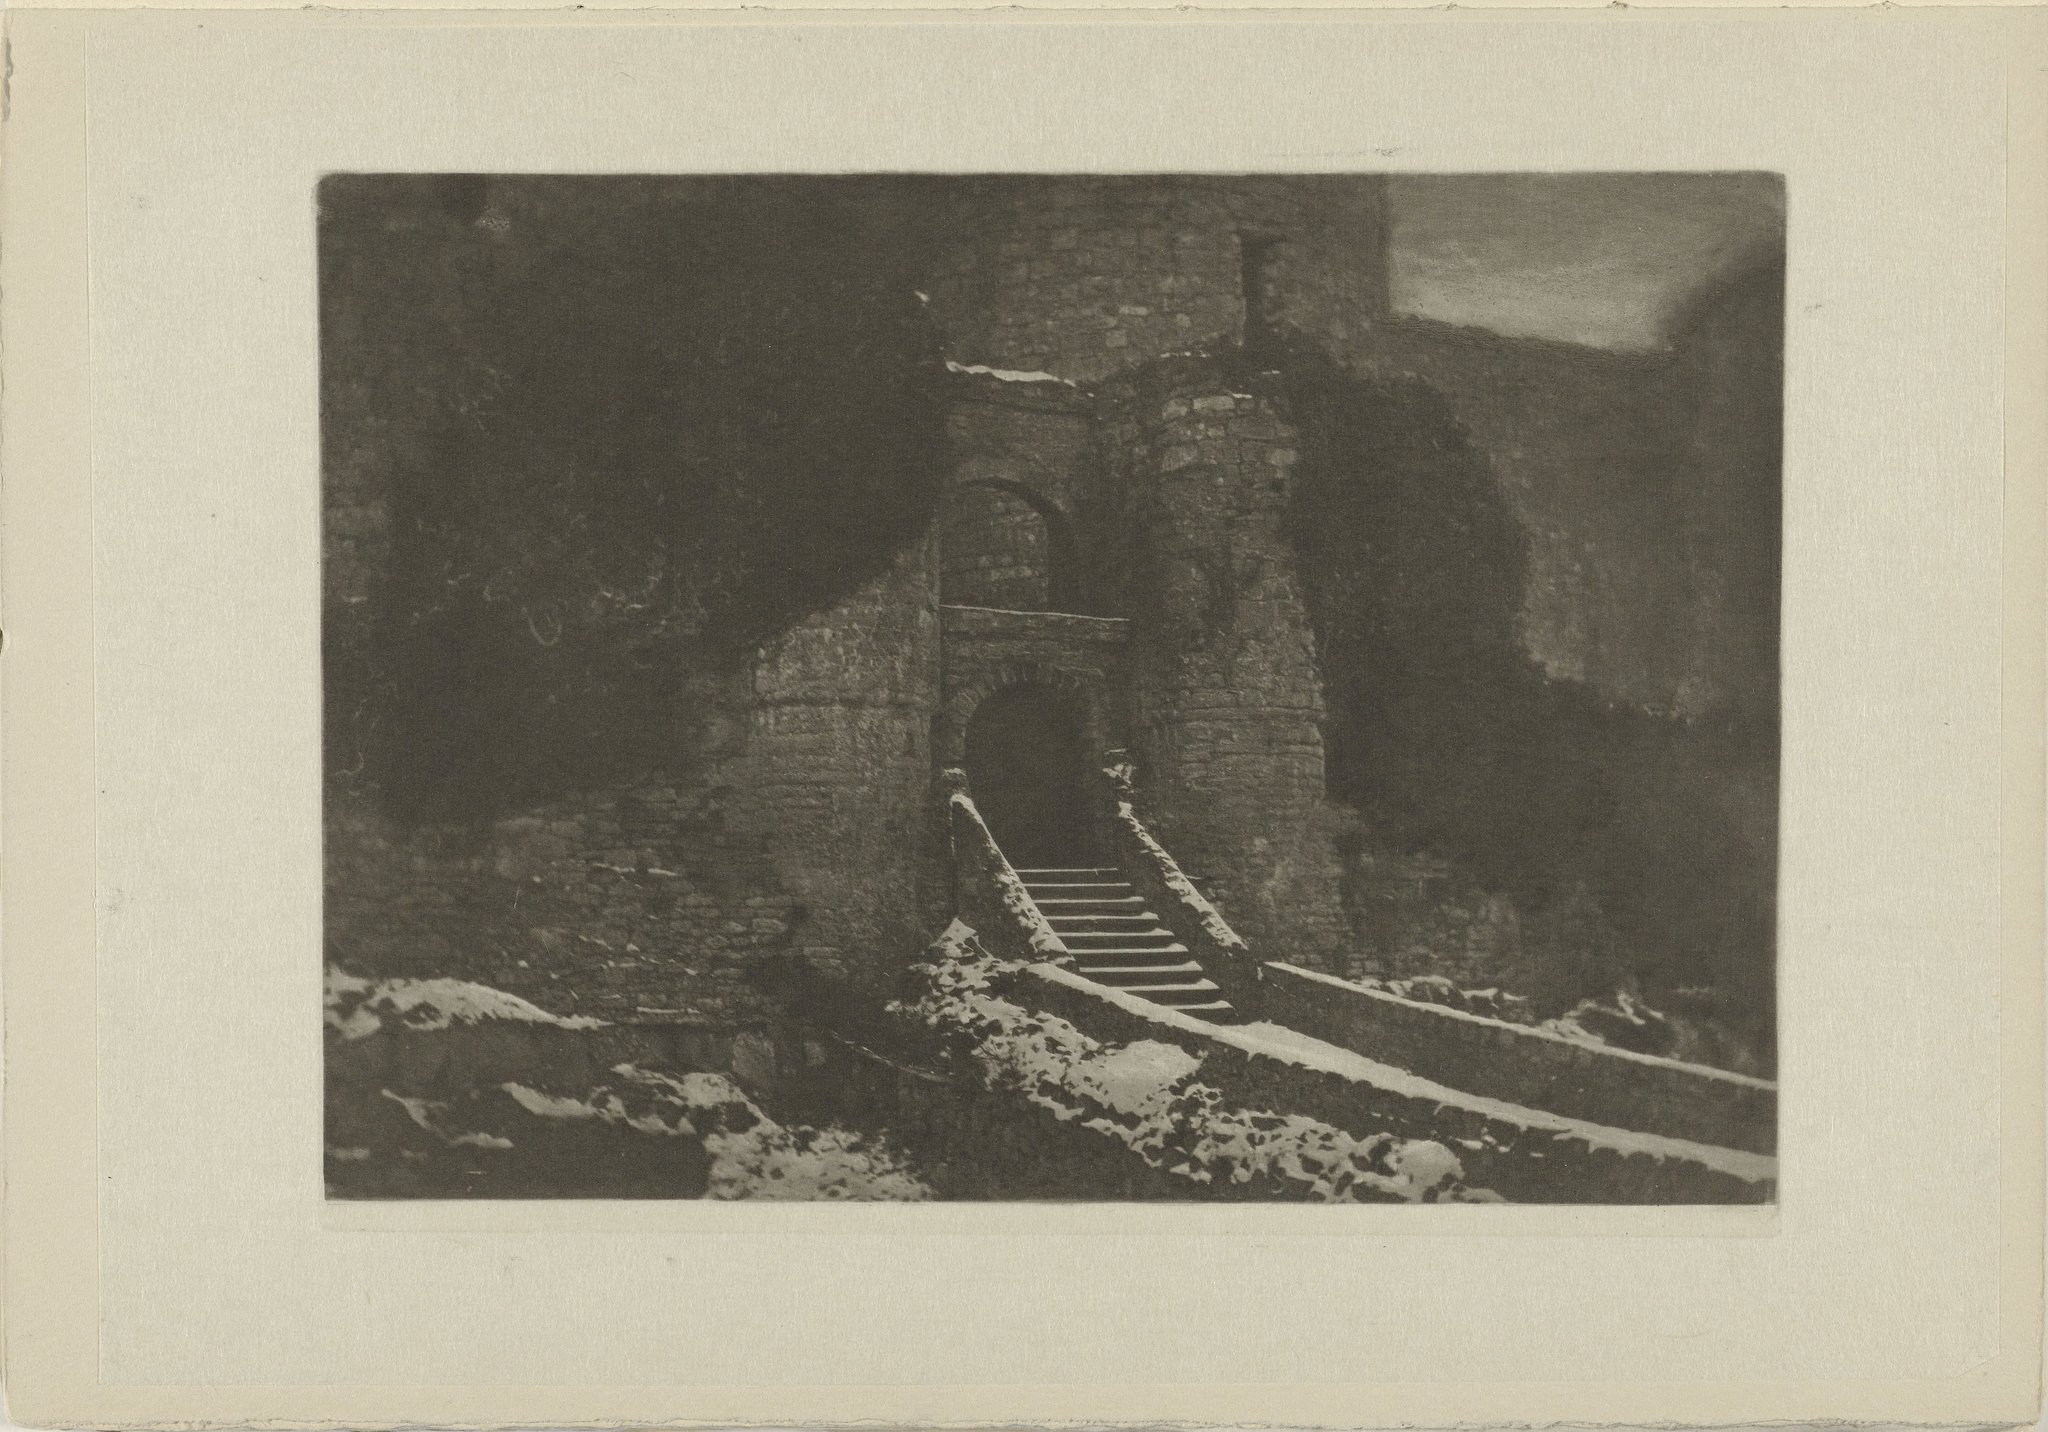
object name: page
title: Harlech Castle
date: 1910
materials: paper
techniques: photoaquatint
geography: wales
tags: castle, snow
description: Plaat 3 uit: Alfred Stieglitz, Camera Work: A photographic quarterly 32 (1910).